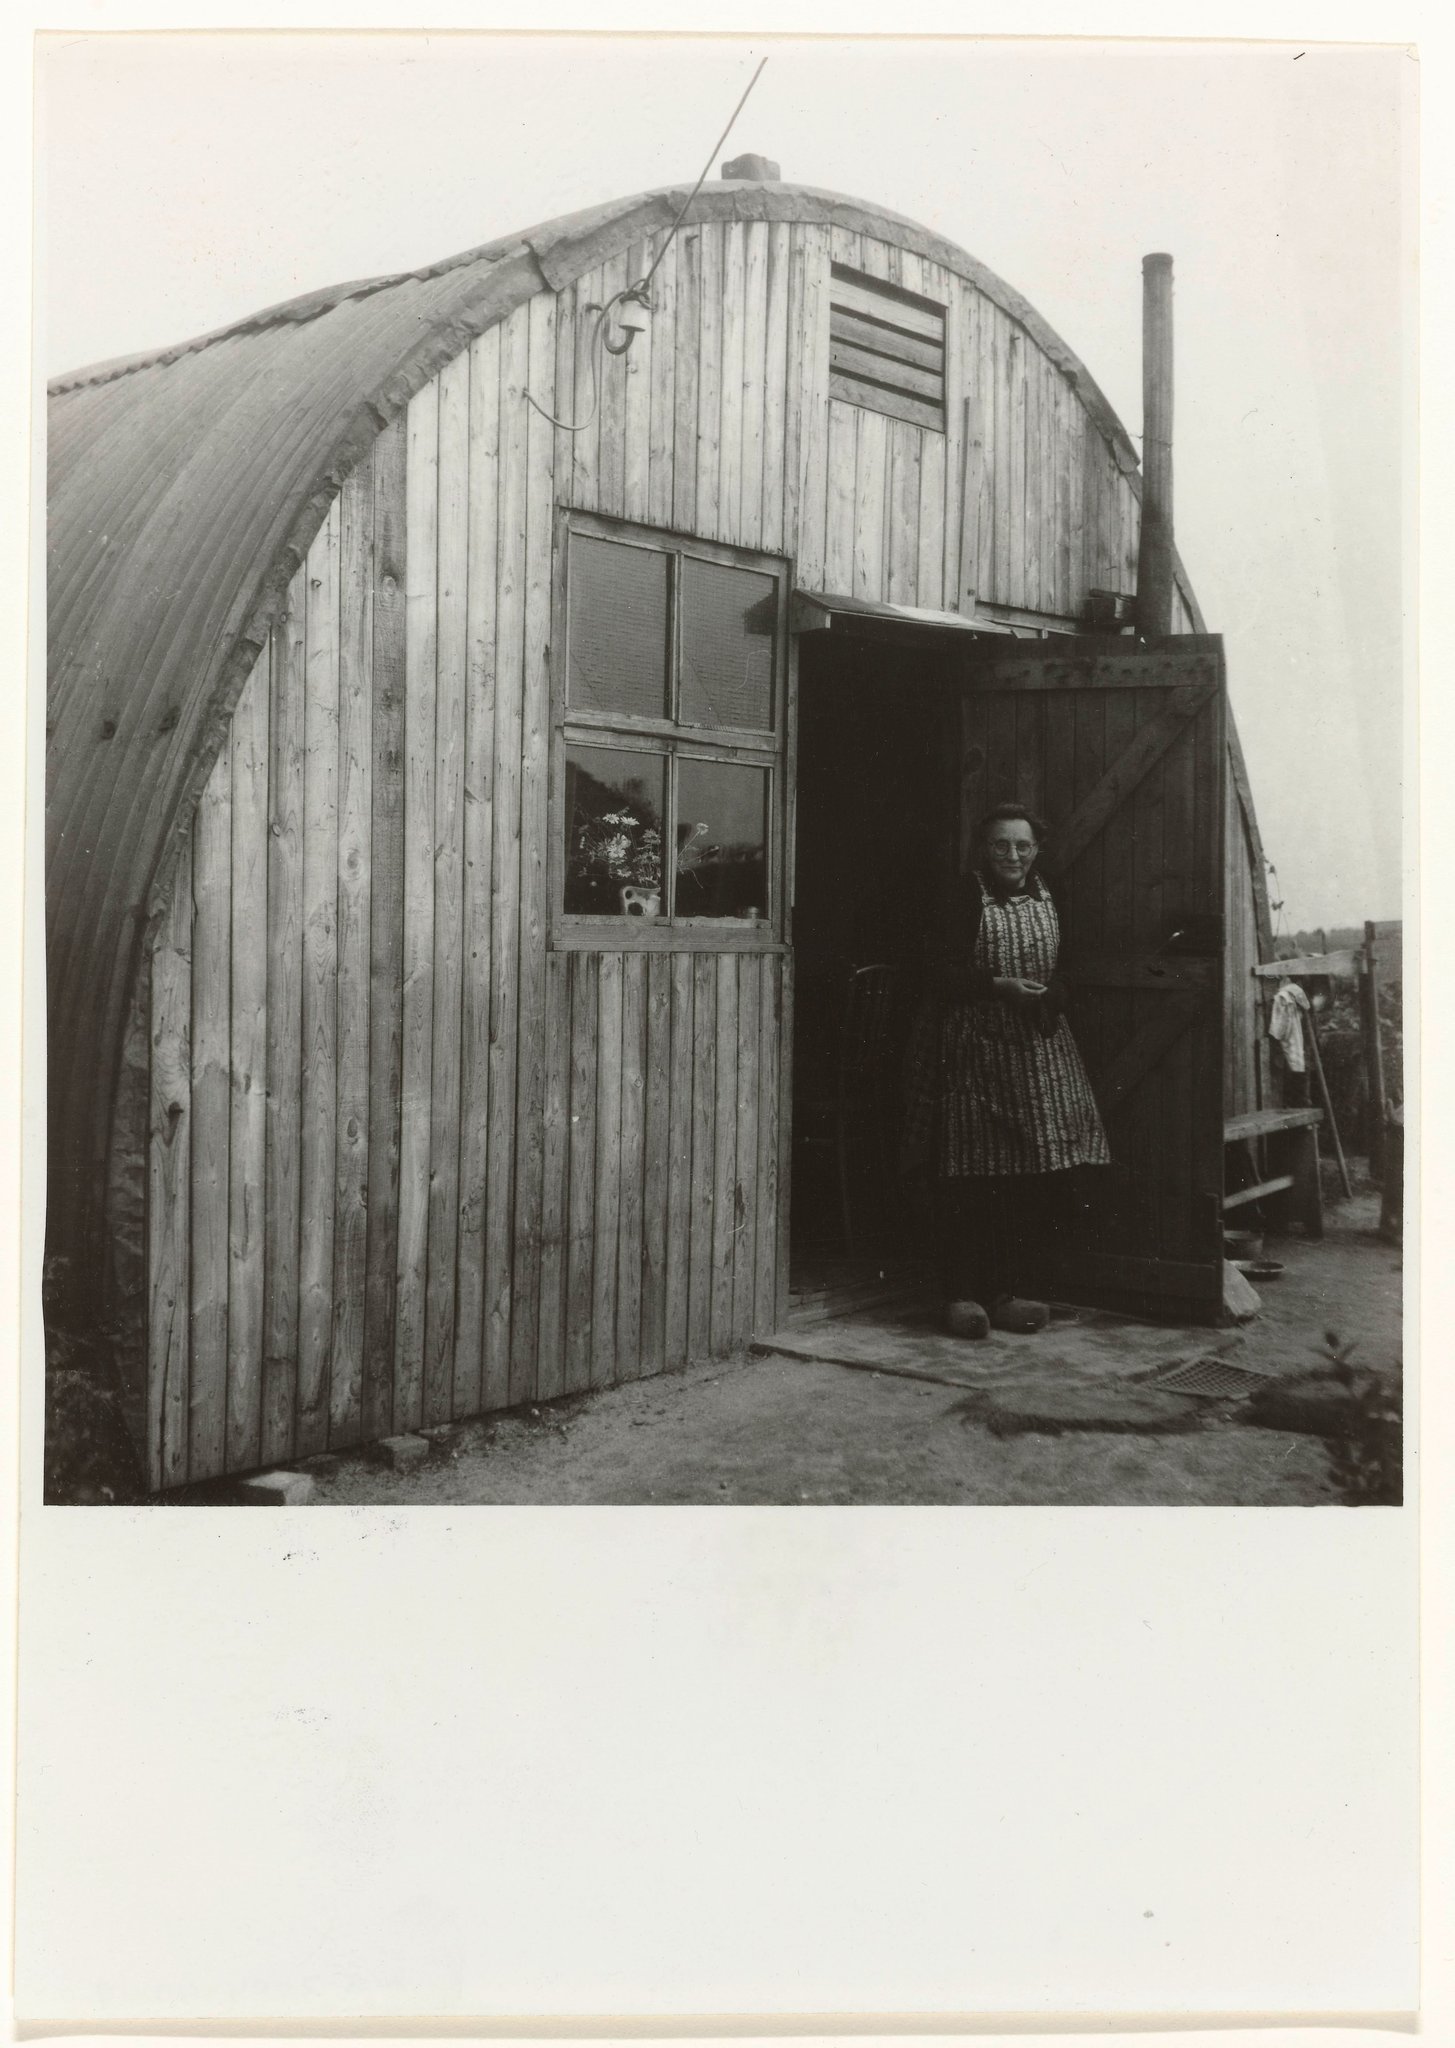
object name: documentary photograph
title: Vrouw in de deuropening van een geïmproviseerde woning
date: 1945-1947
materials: photographic support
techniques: photography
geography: netherlands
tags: publisher, netherlands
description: In een deuropening staat een vrouw, links van haar is een raam. Het geïmproviseerde huis is gemaakt uit een zogenaamde "Nissenhut", een soort hangar voor militair gebruik.